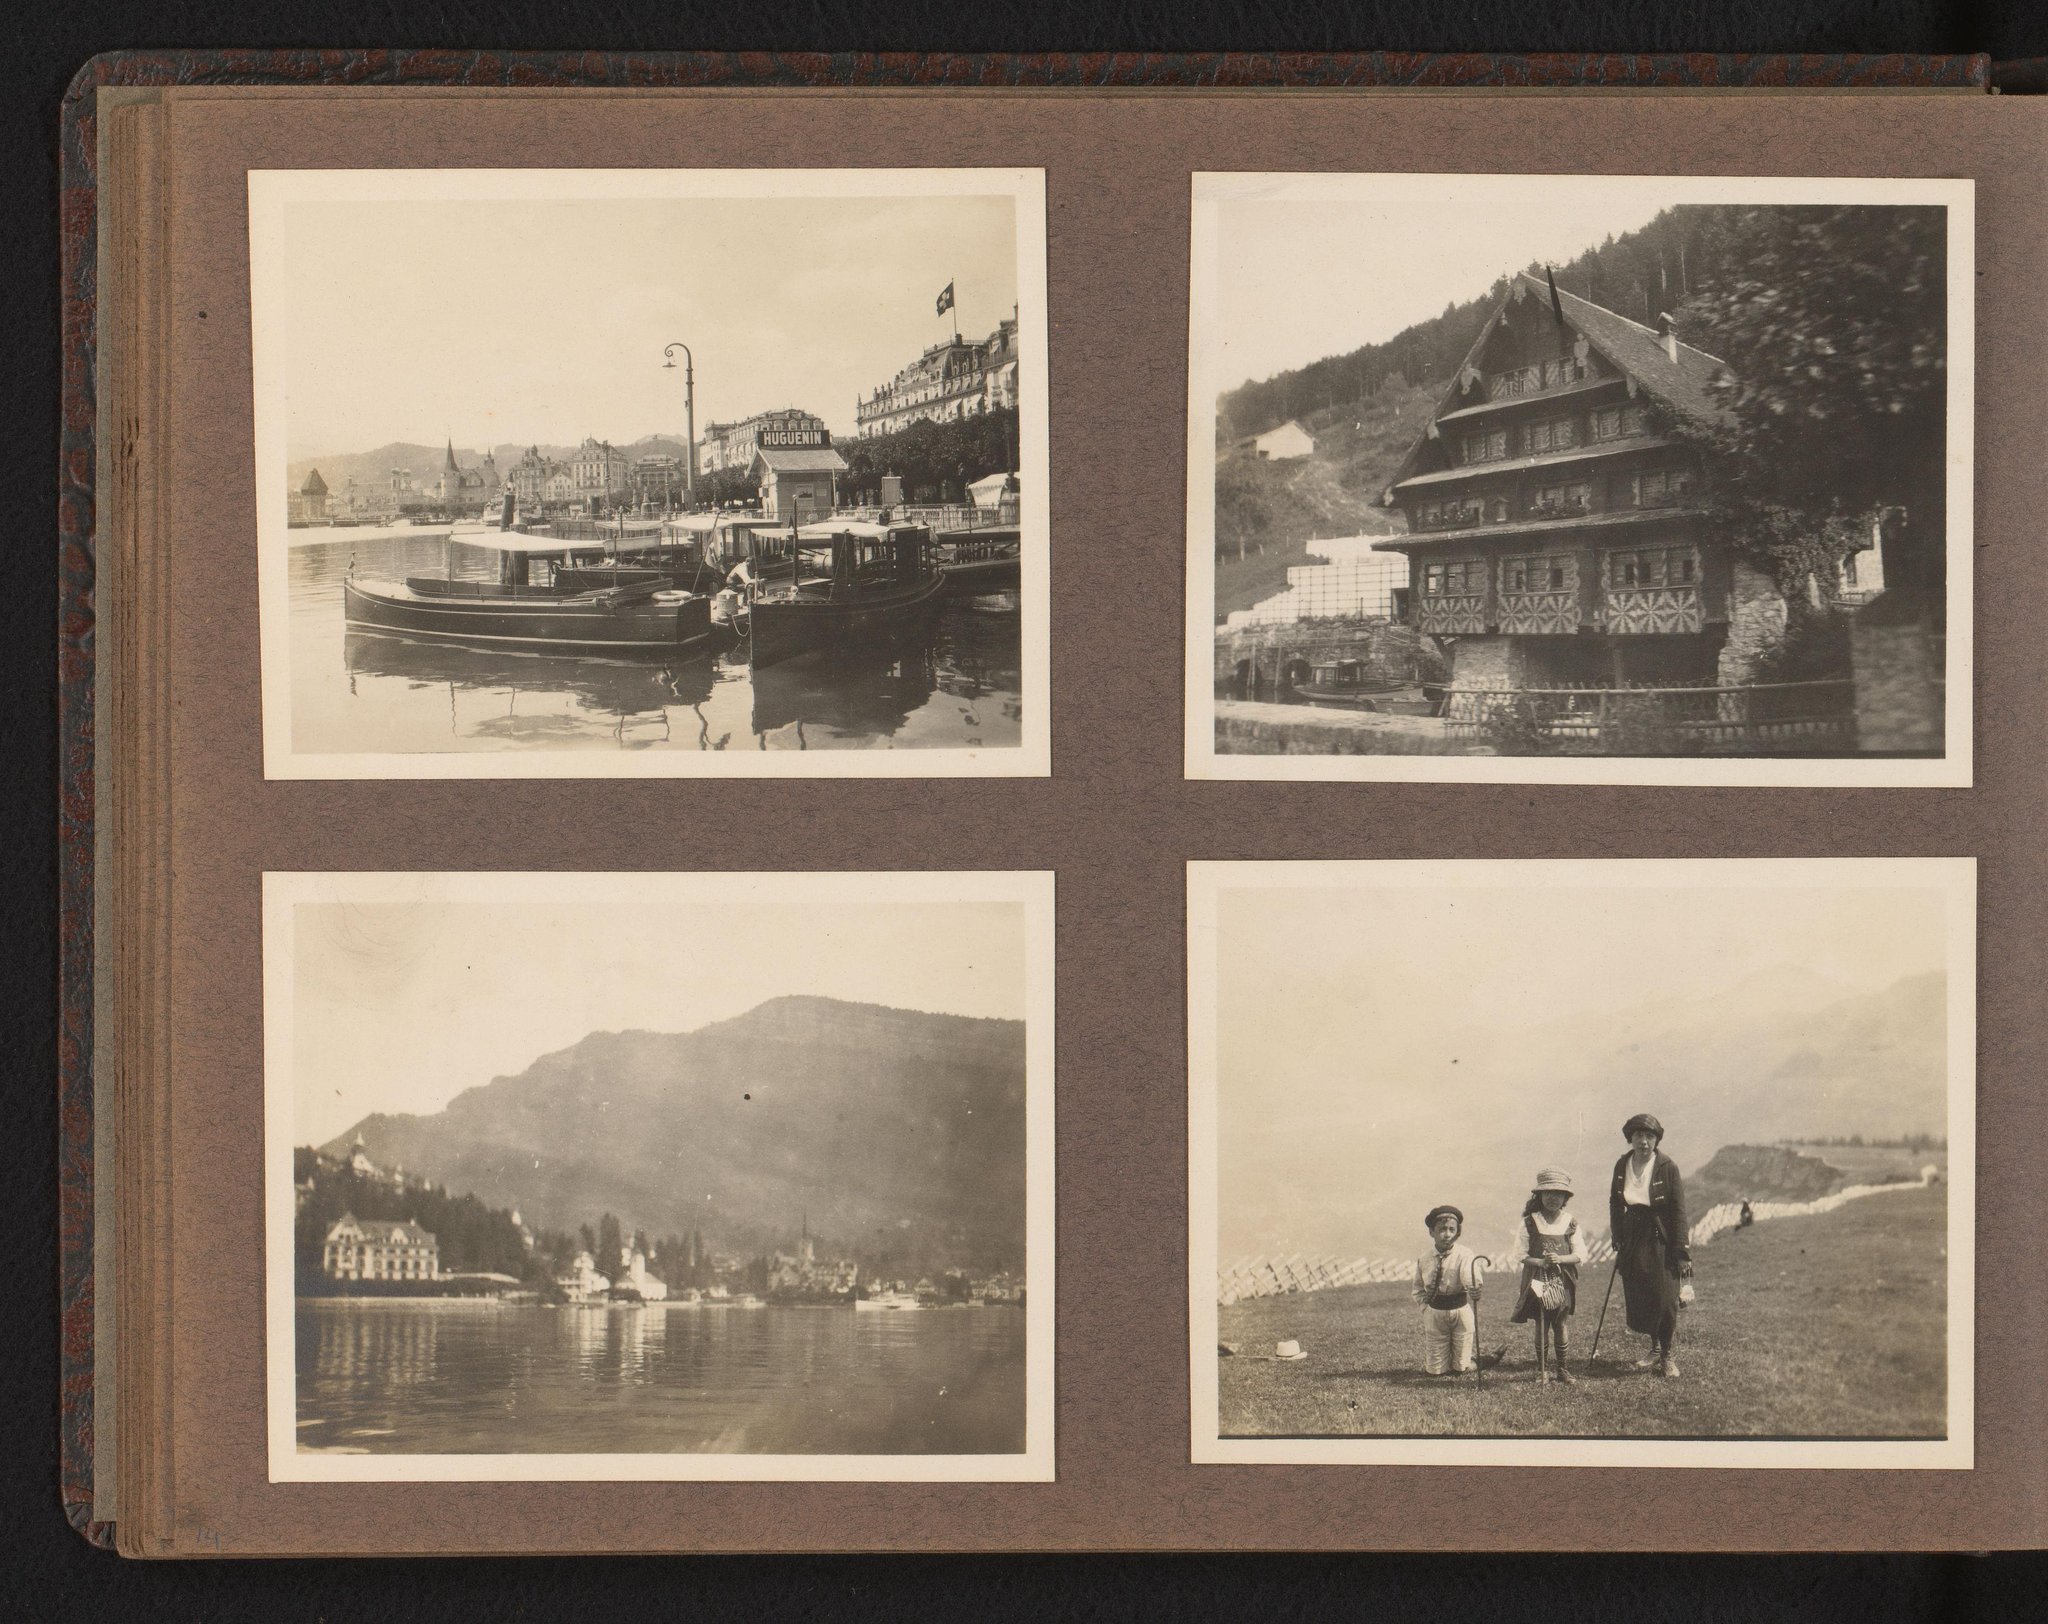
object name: photograph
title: Vier foto's van de familie op vakantie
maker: frédéric gabriël dumas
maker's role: engineer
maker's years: 1886-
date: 1919-1923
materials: cardboard, photographic support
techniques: gelatin silver print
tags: surabaya, paris, beatrice jacqueline eveline dumas, outing, pleasure trip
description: Blad met vier foto's van de familie op vakantie, bij een meer en in de bergen, mogelijk Zwitserland. Onderdeel van een fotoalbum over de kindertijd van Eef Dumas met de familie op reis door Europa, ca. 1919-1923.